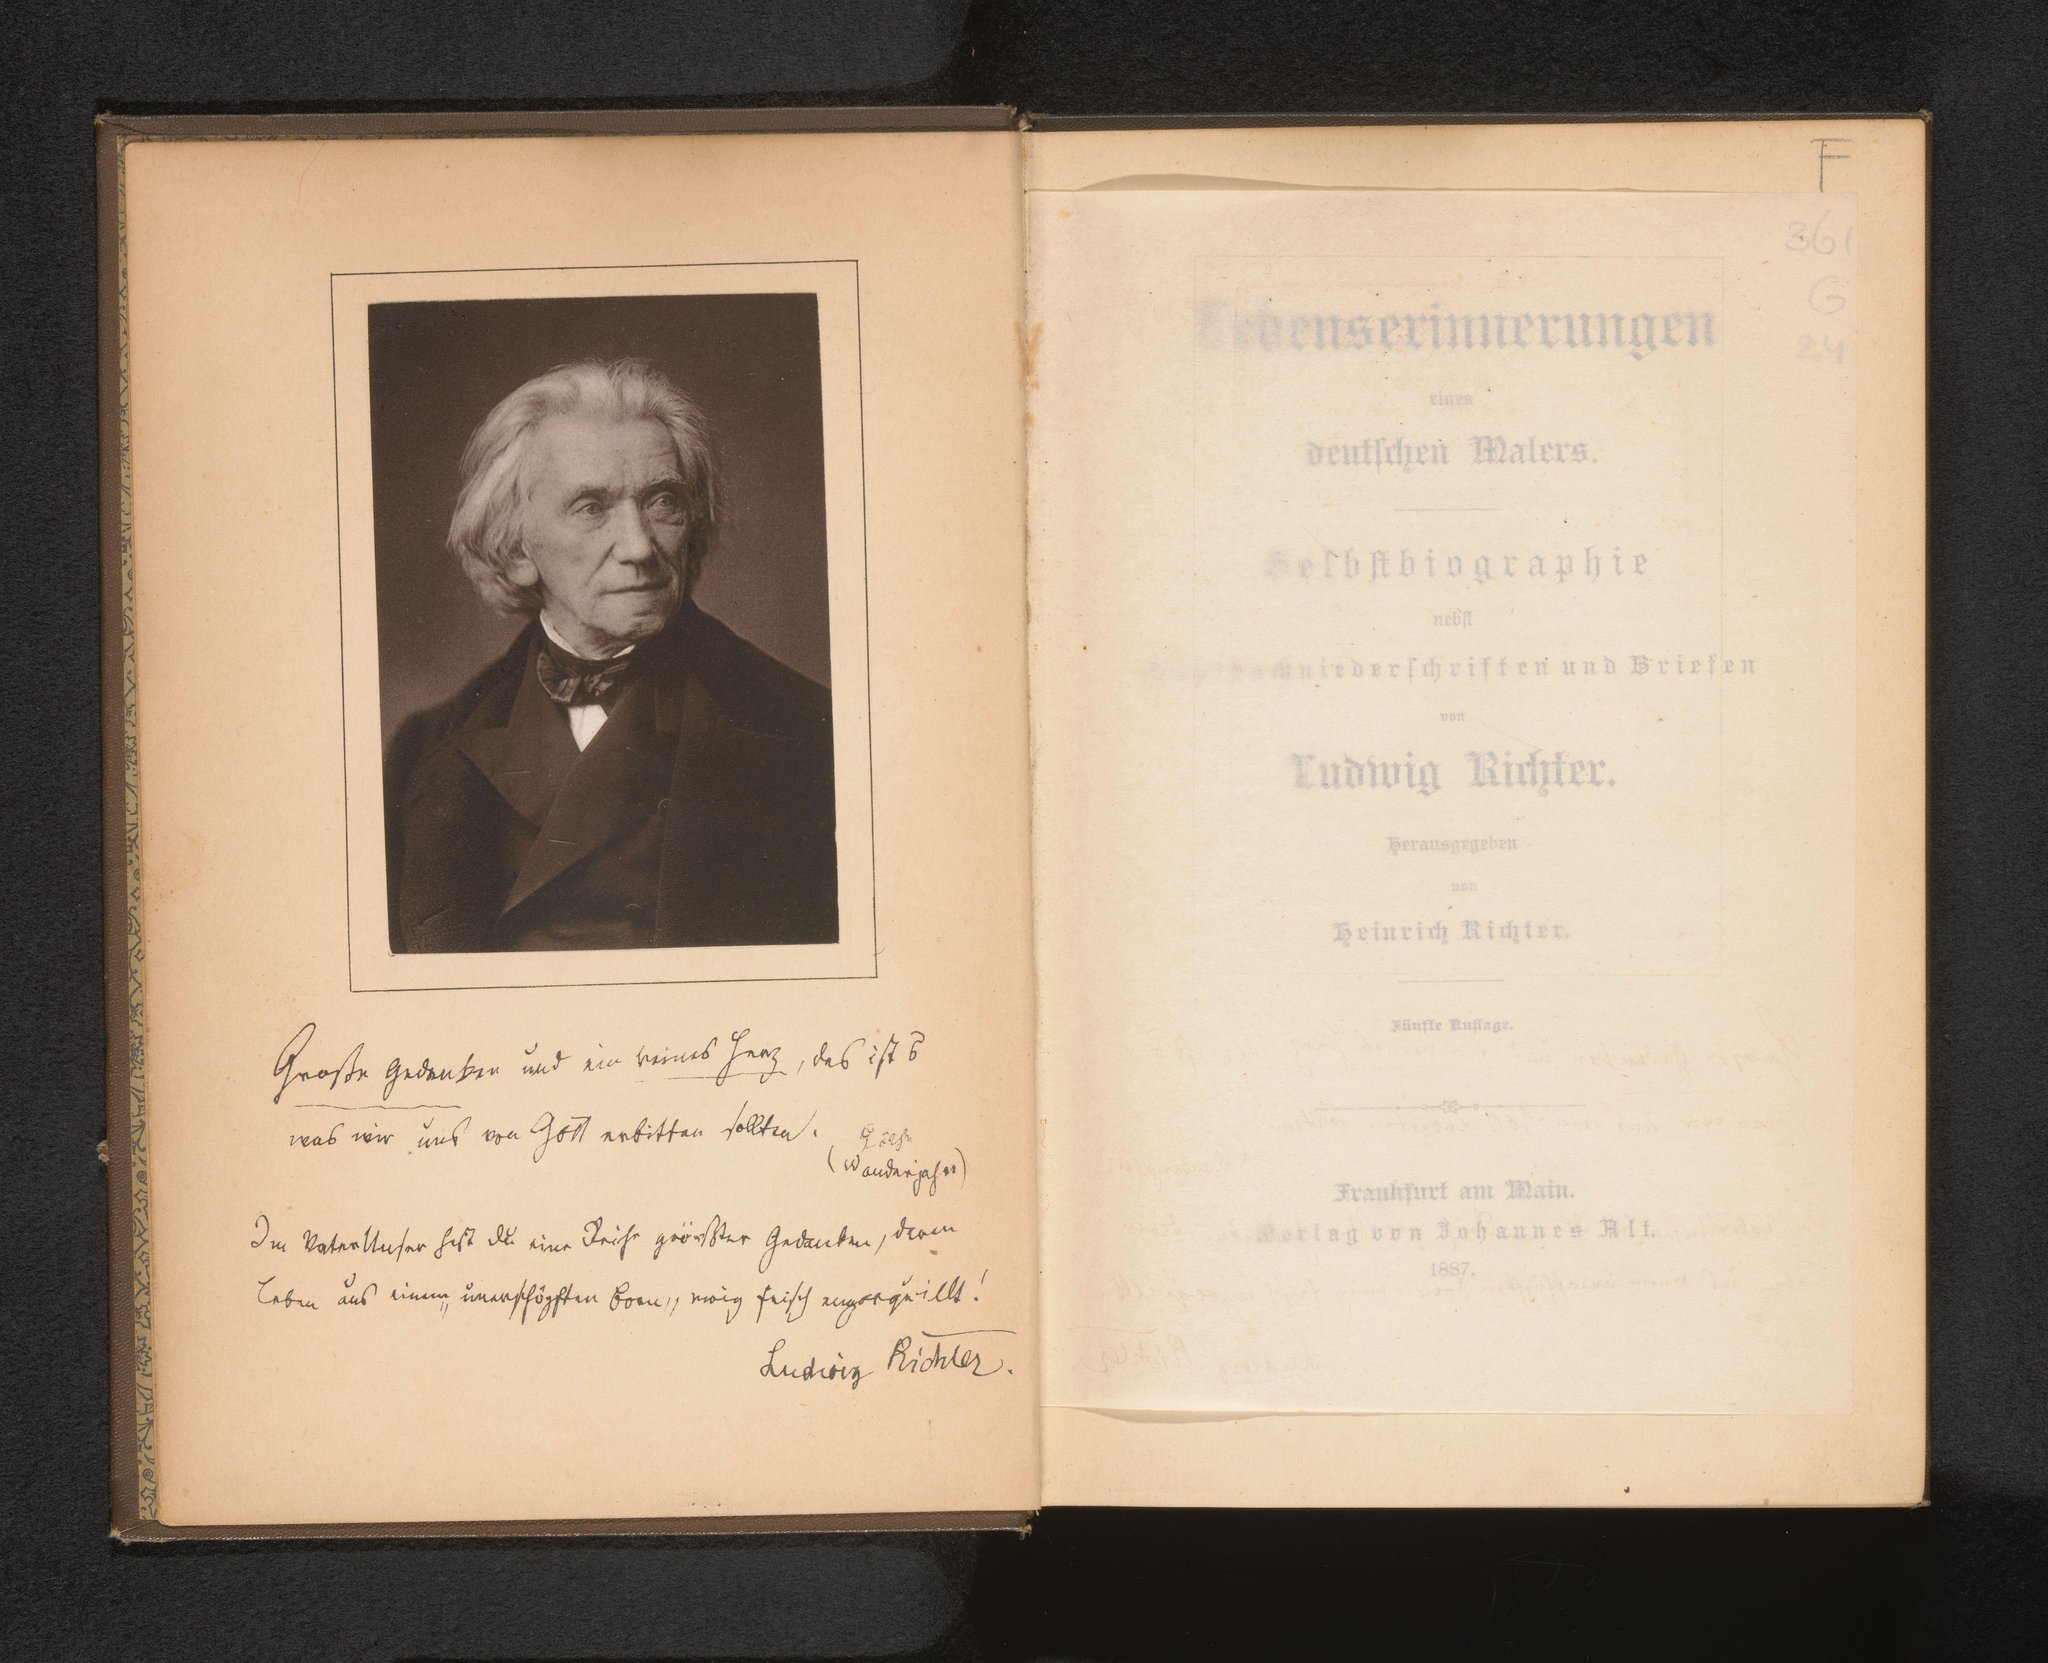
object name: photomechanical print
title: Portret van Ludwig Richter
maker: Anonymous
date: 1882-1887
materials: paper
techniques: photograph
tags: painter, print maker, ludwig richter, historical persons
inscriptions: annotation: ‘(...)’